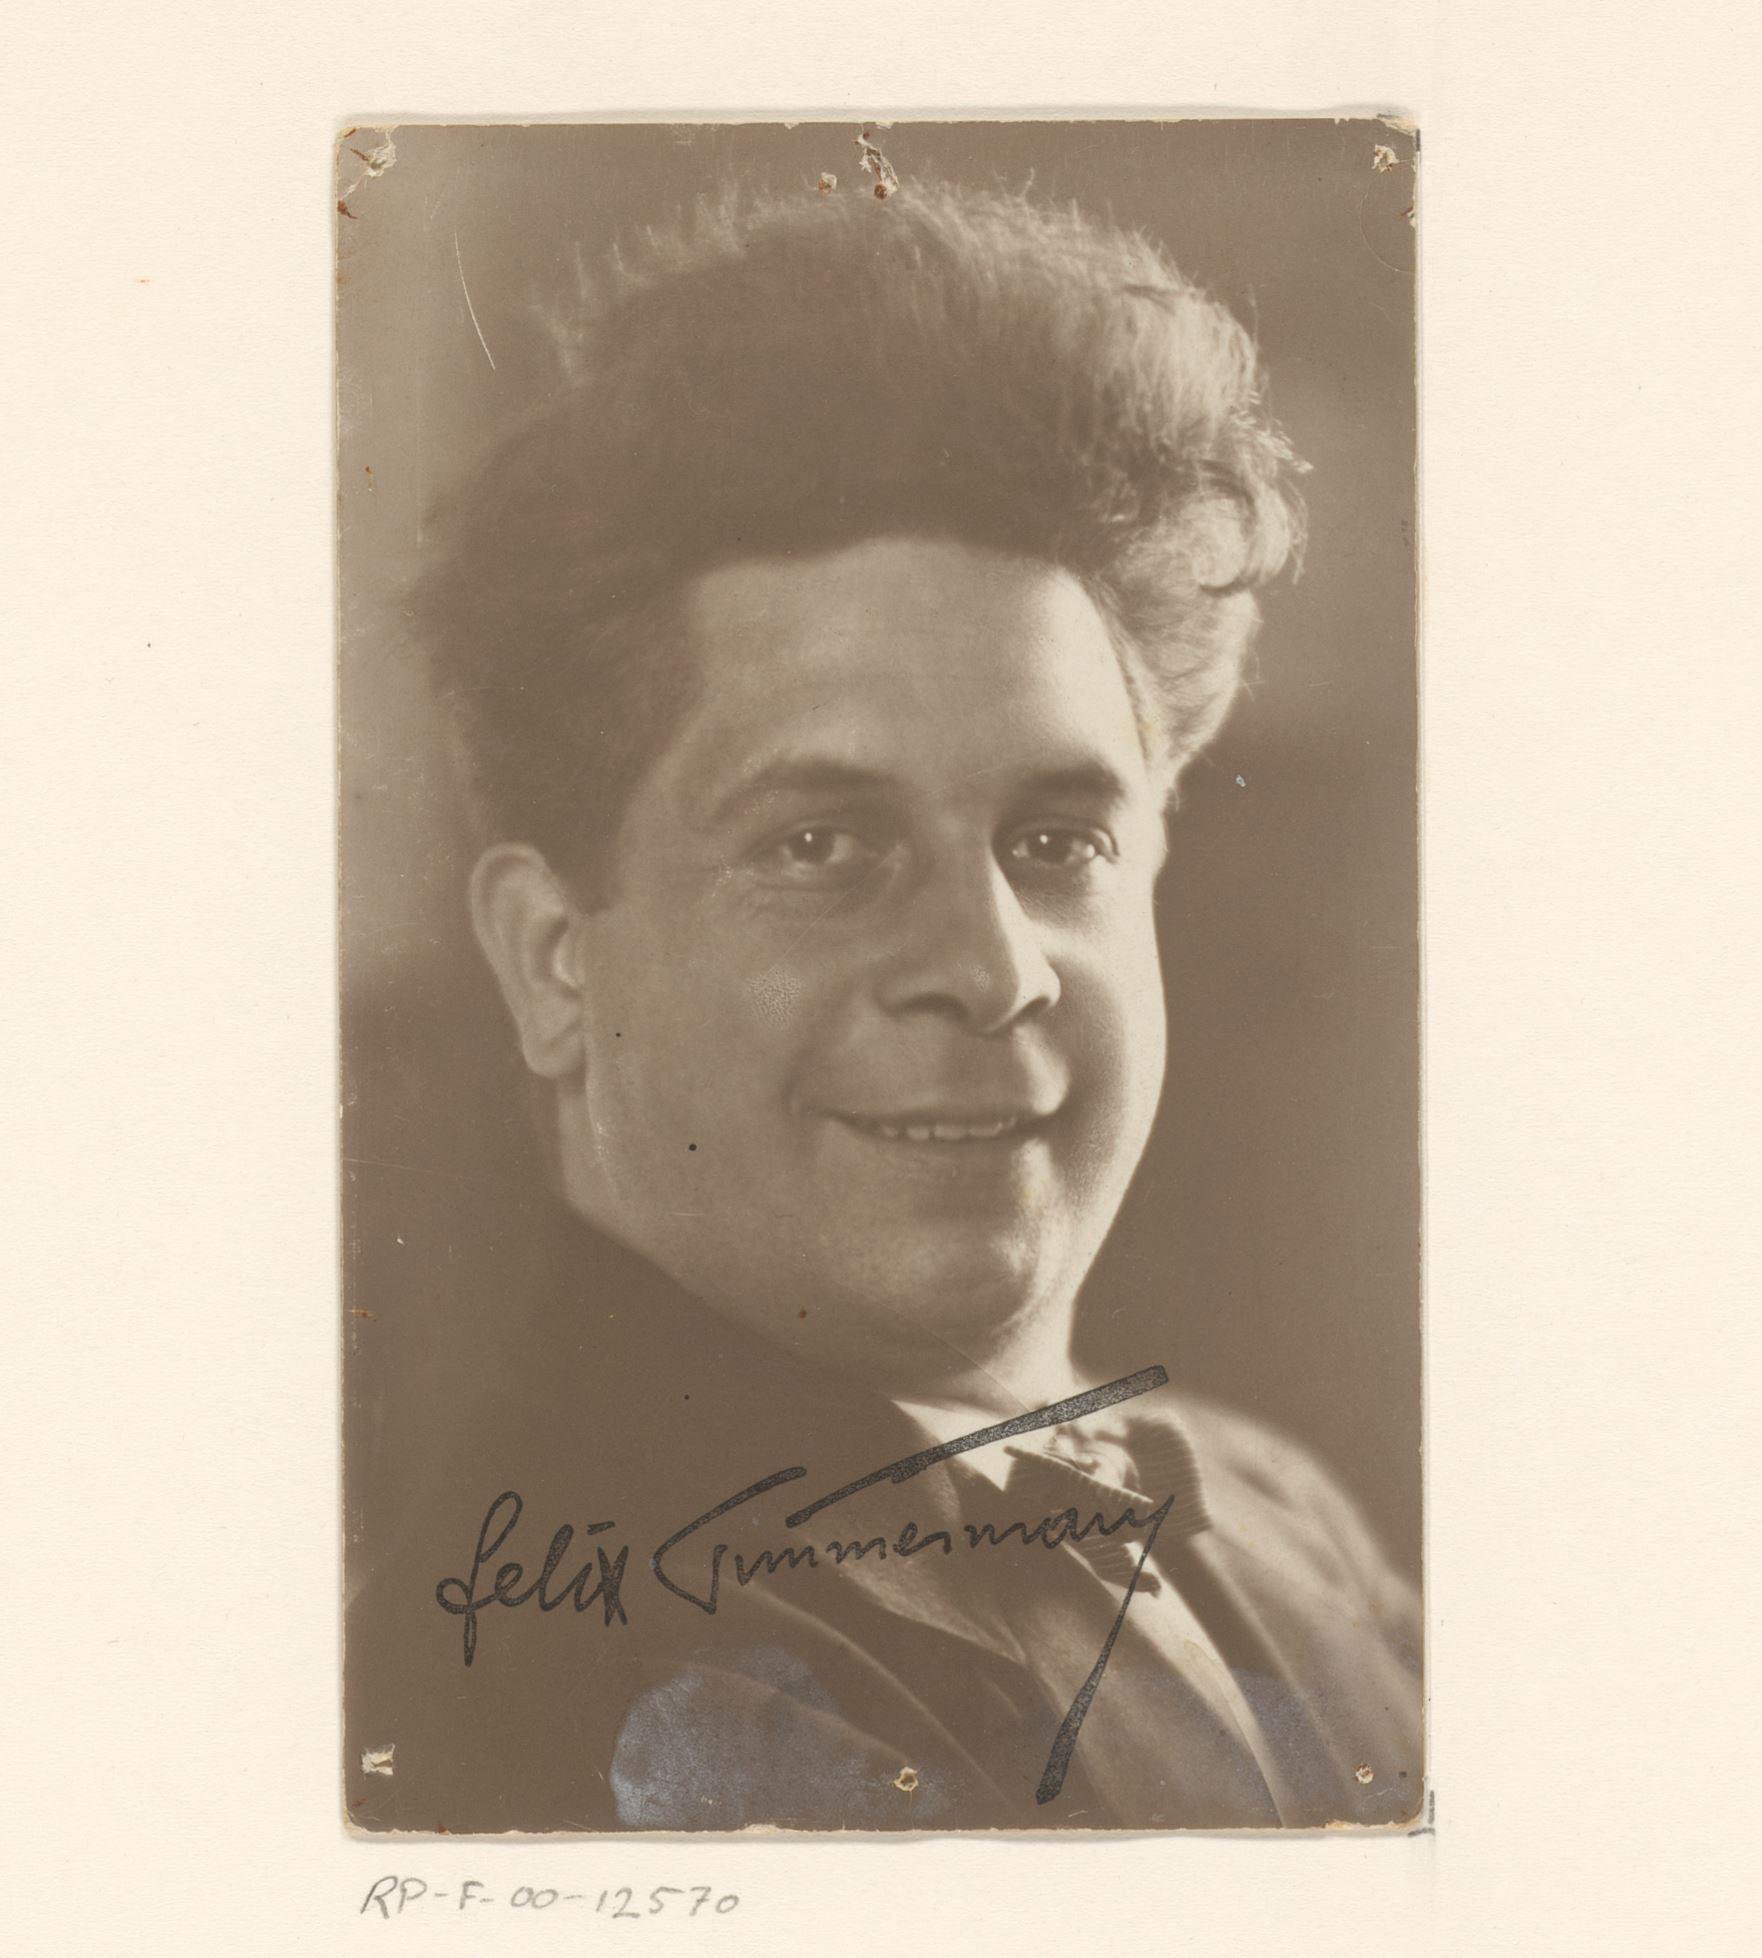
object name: ansichtkaart, prentbriefkaart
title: Portret van Felix Timmermans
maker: gyselinck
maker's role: fotograaf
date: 1921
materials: paper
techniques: gelatin silver print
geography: tielt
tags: lierre, print maker, felix timmermans, historical persons